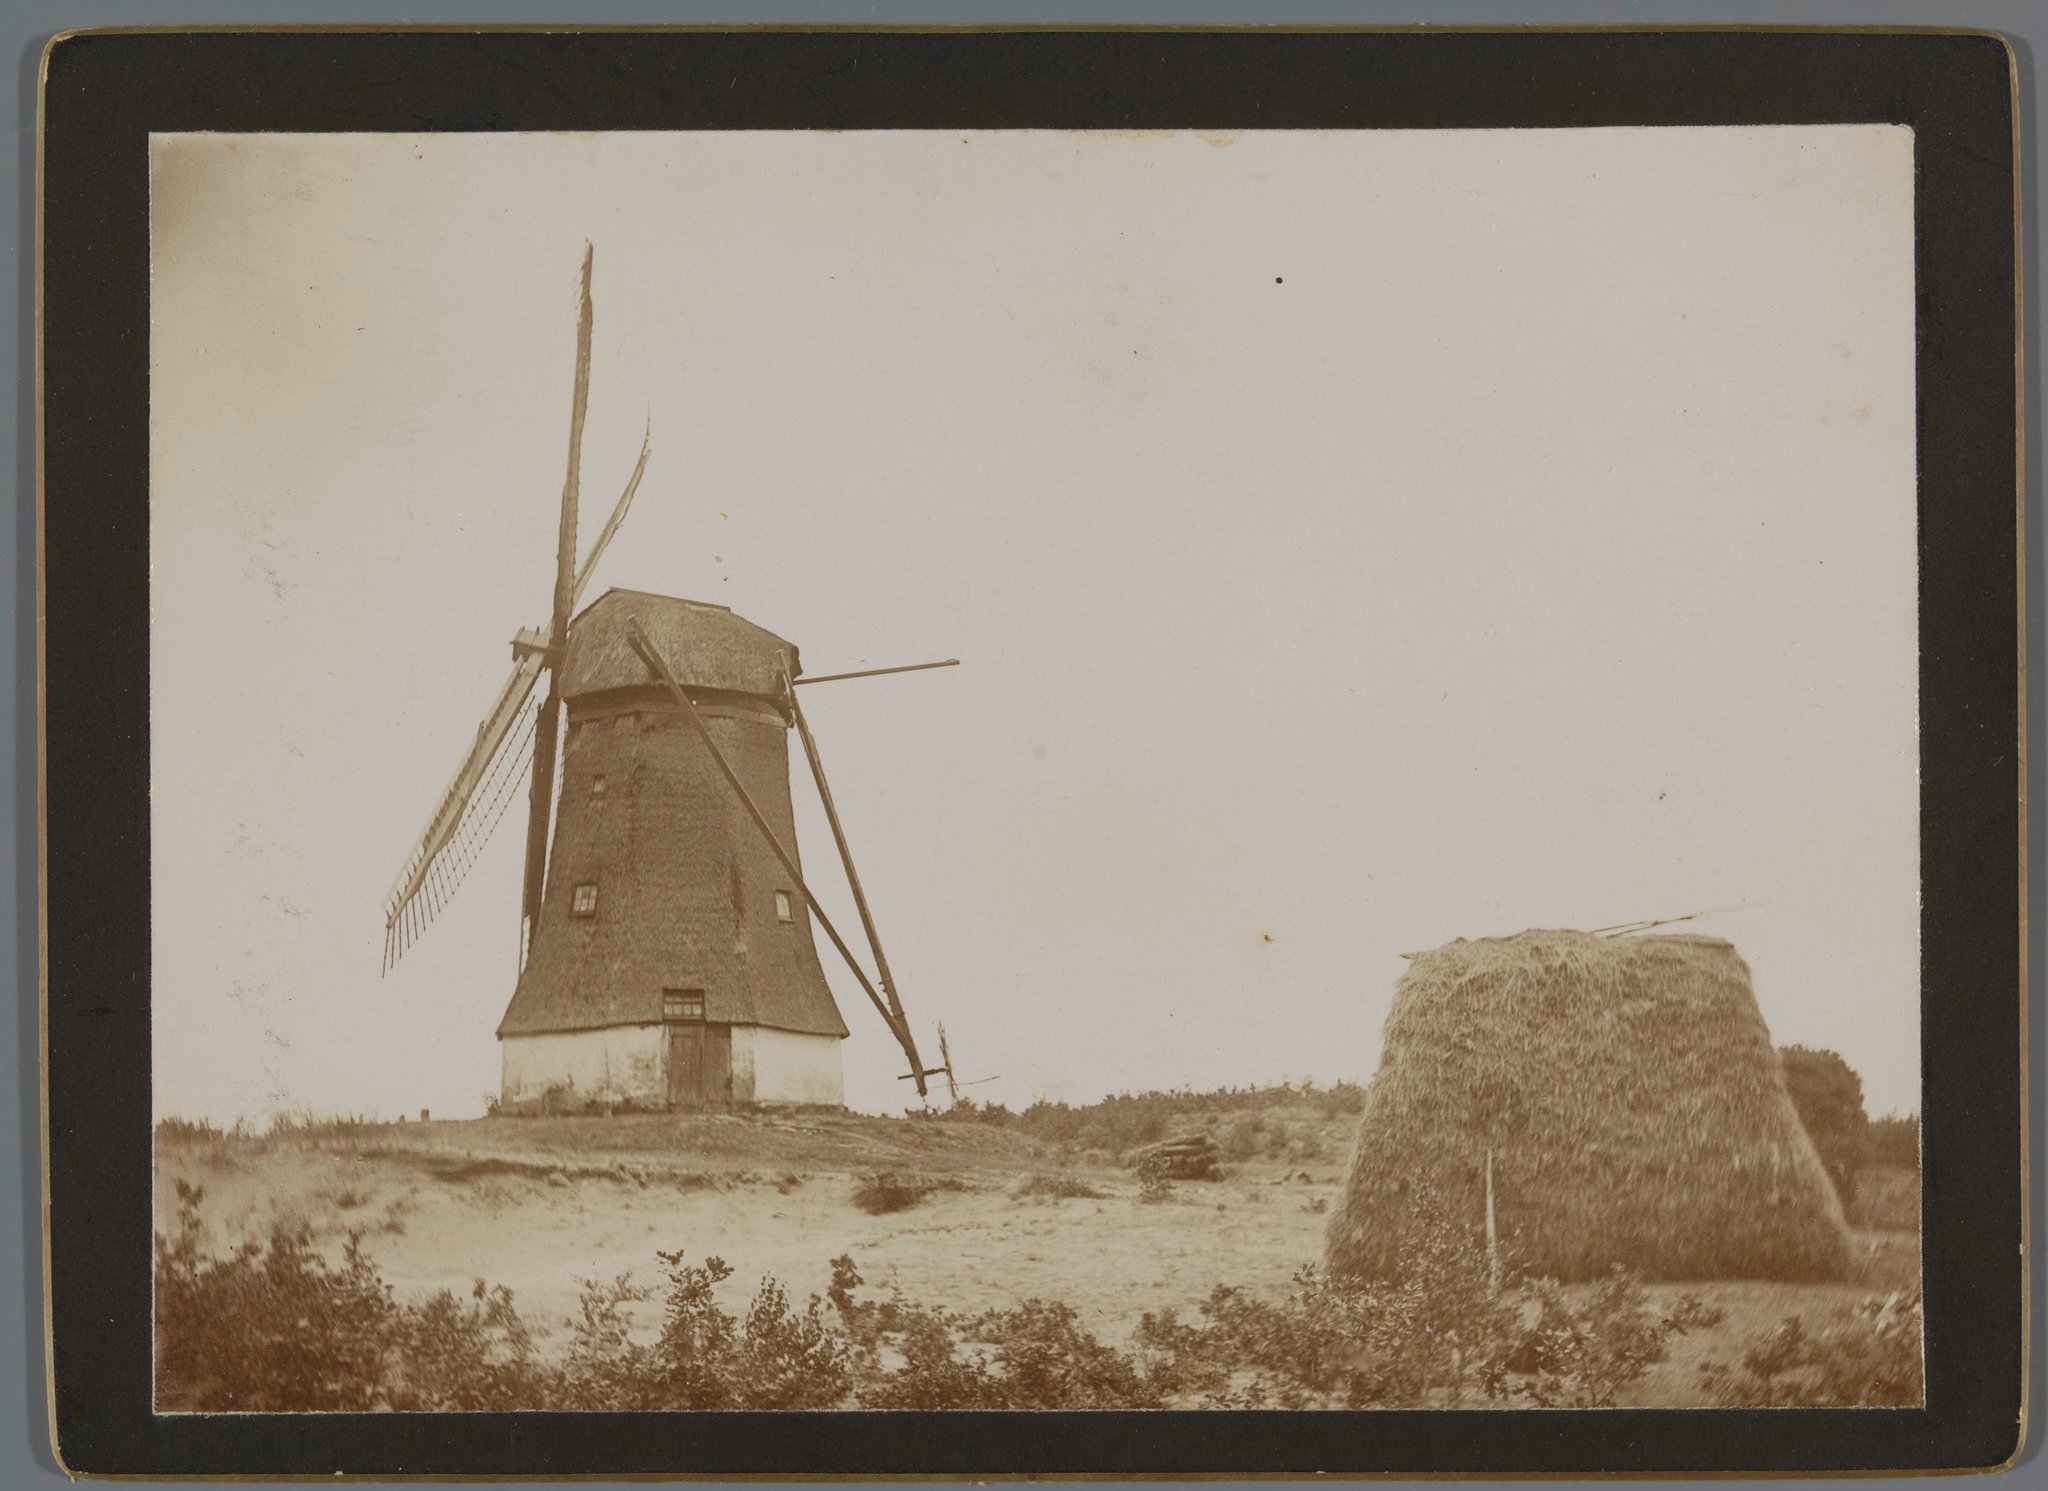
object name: photograph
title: Gezicht op de molen De Vlijt in Wapenveld met rechts een hooiopper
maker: cornelia hendrika jonker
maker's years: 1874-1924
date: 1880-1940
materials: cardboard, photographic support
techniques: collodion silver print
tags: windmill in landscape, hay-cock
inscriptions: annotation: ‘C’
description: Gezicht op de molen van Wapenveld, dichtbij Hattem, in de gemeente Heerde. De molen is in 1981 totaal afgebrand en in 1984 herbouwd.